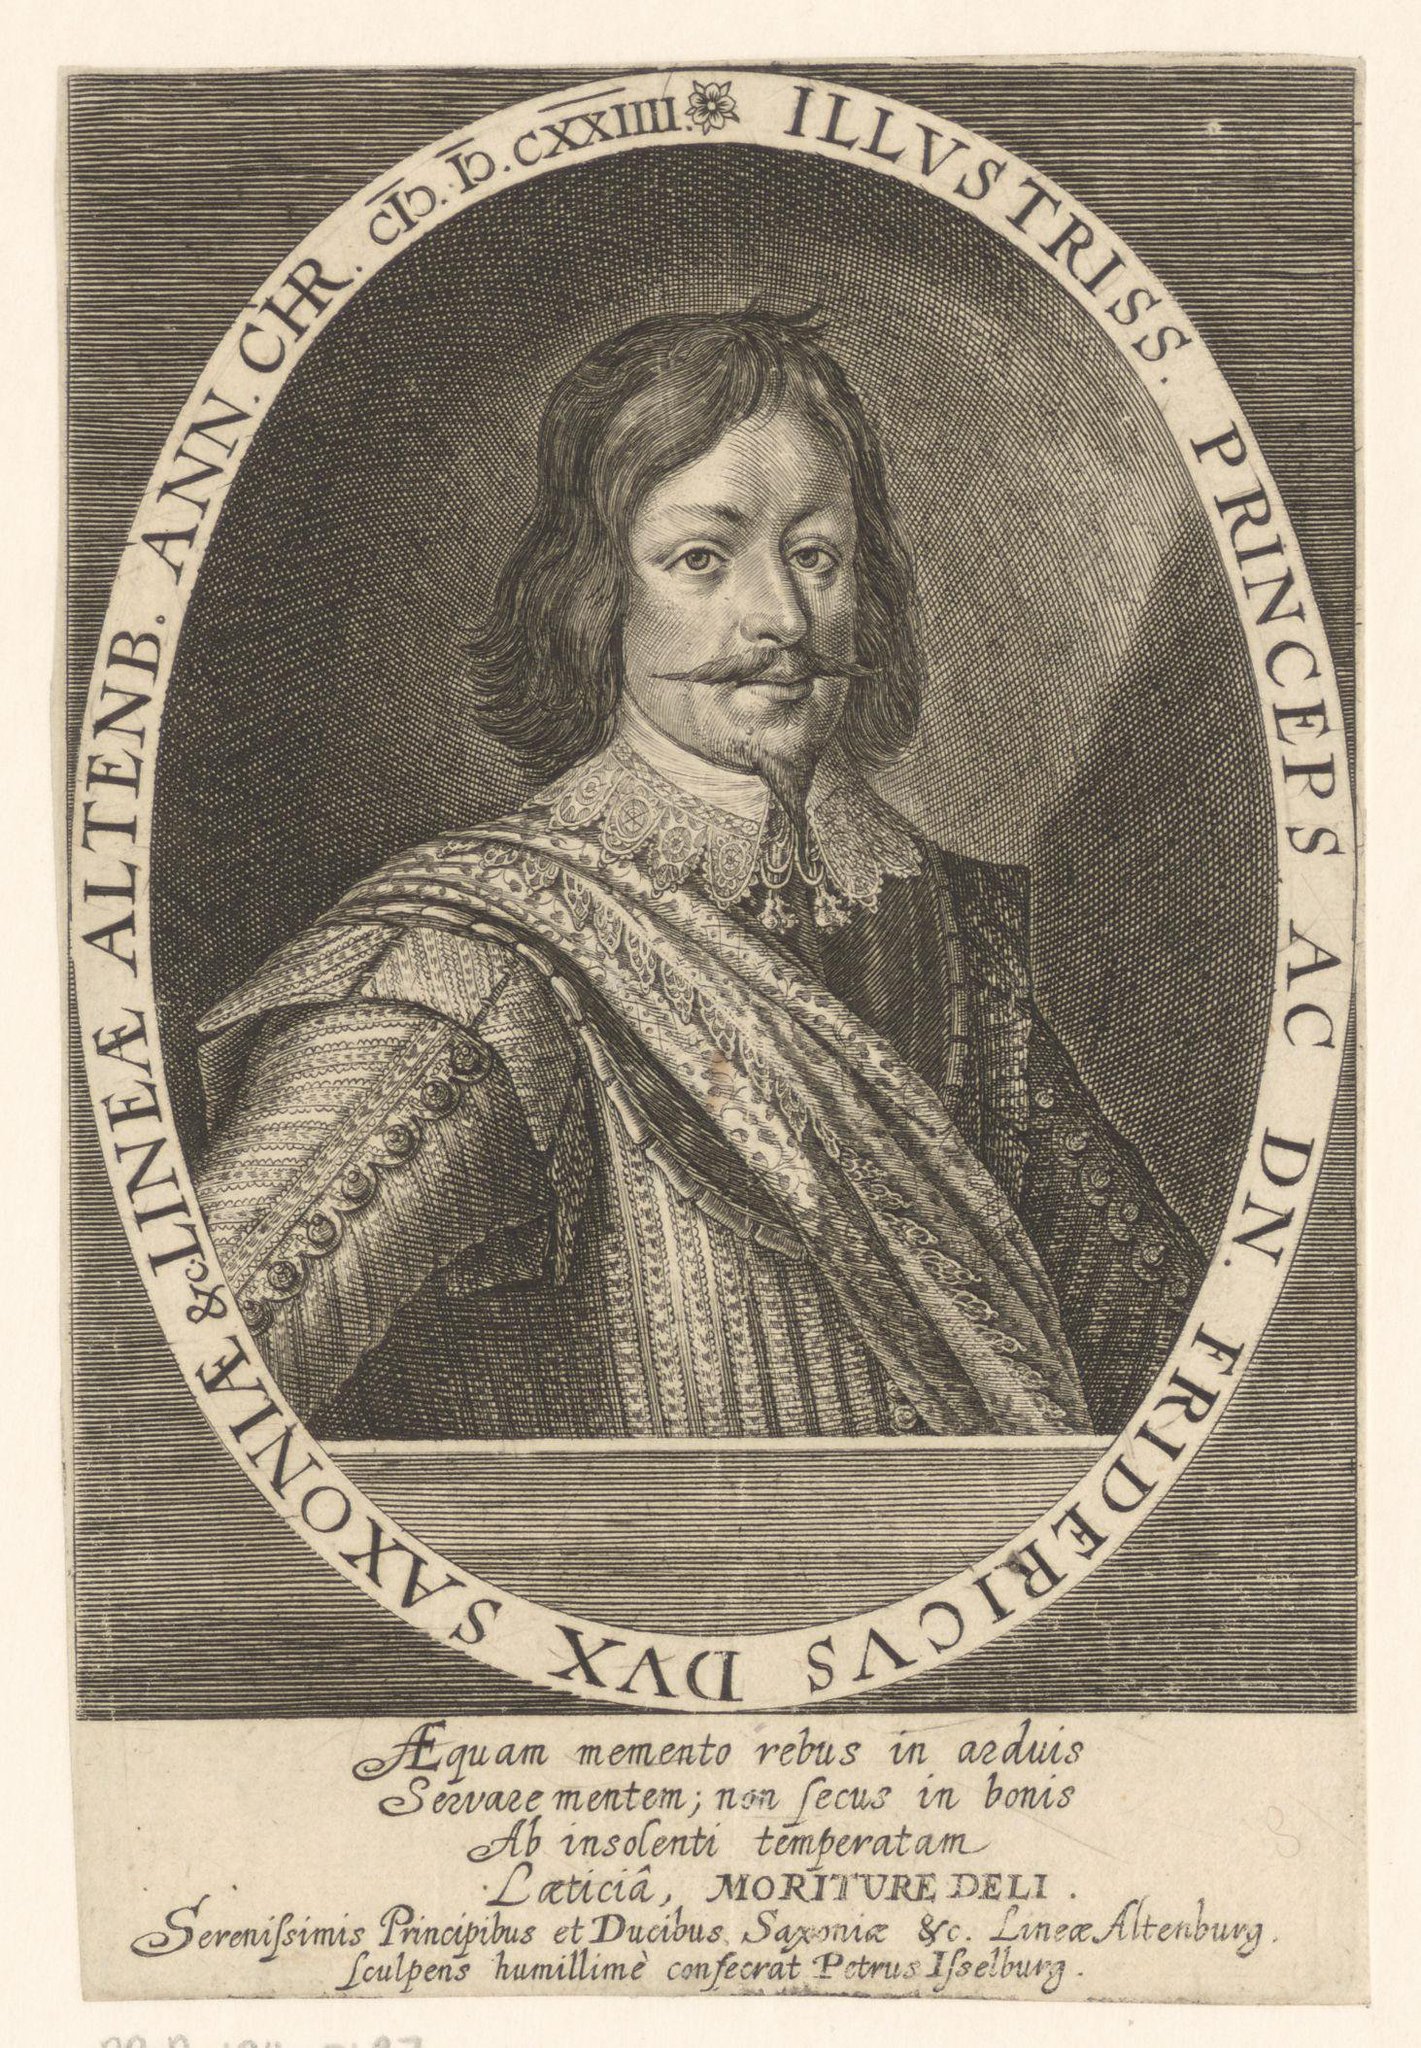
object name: print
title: Portret van Frederik van Saksen-Altenburg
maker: peter isselburg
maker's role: print maker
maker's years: 1568-1630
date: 1610-1630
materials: paper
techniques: engraving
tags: historical persons, ruler, sovereign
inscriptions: collector's mark: Lugt 2228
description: Tekst in het Latijn in de omlijsting en in de marge.